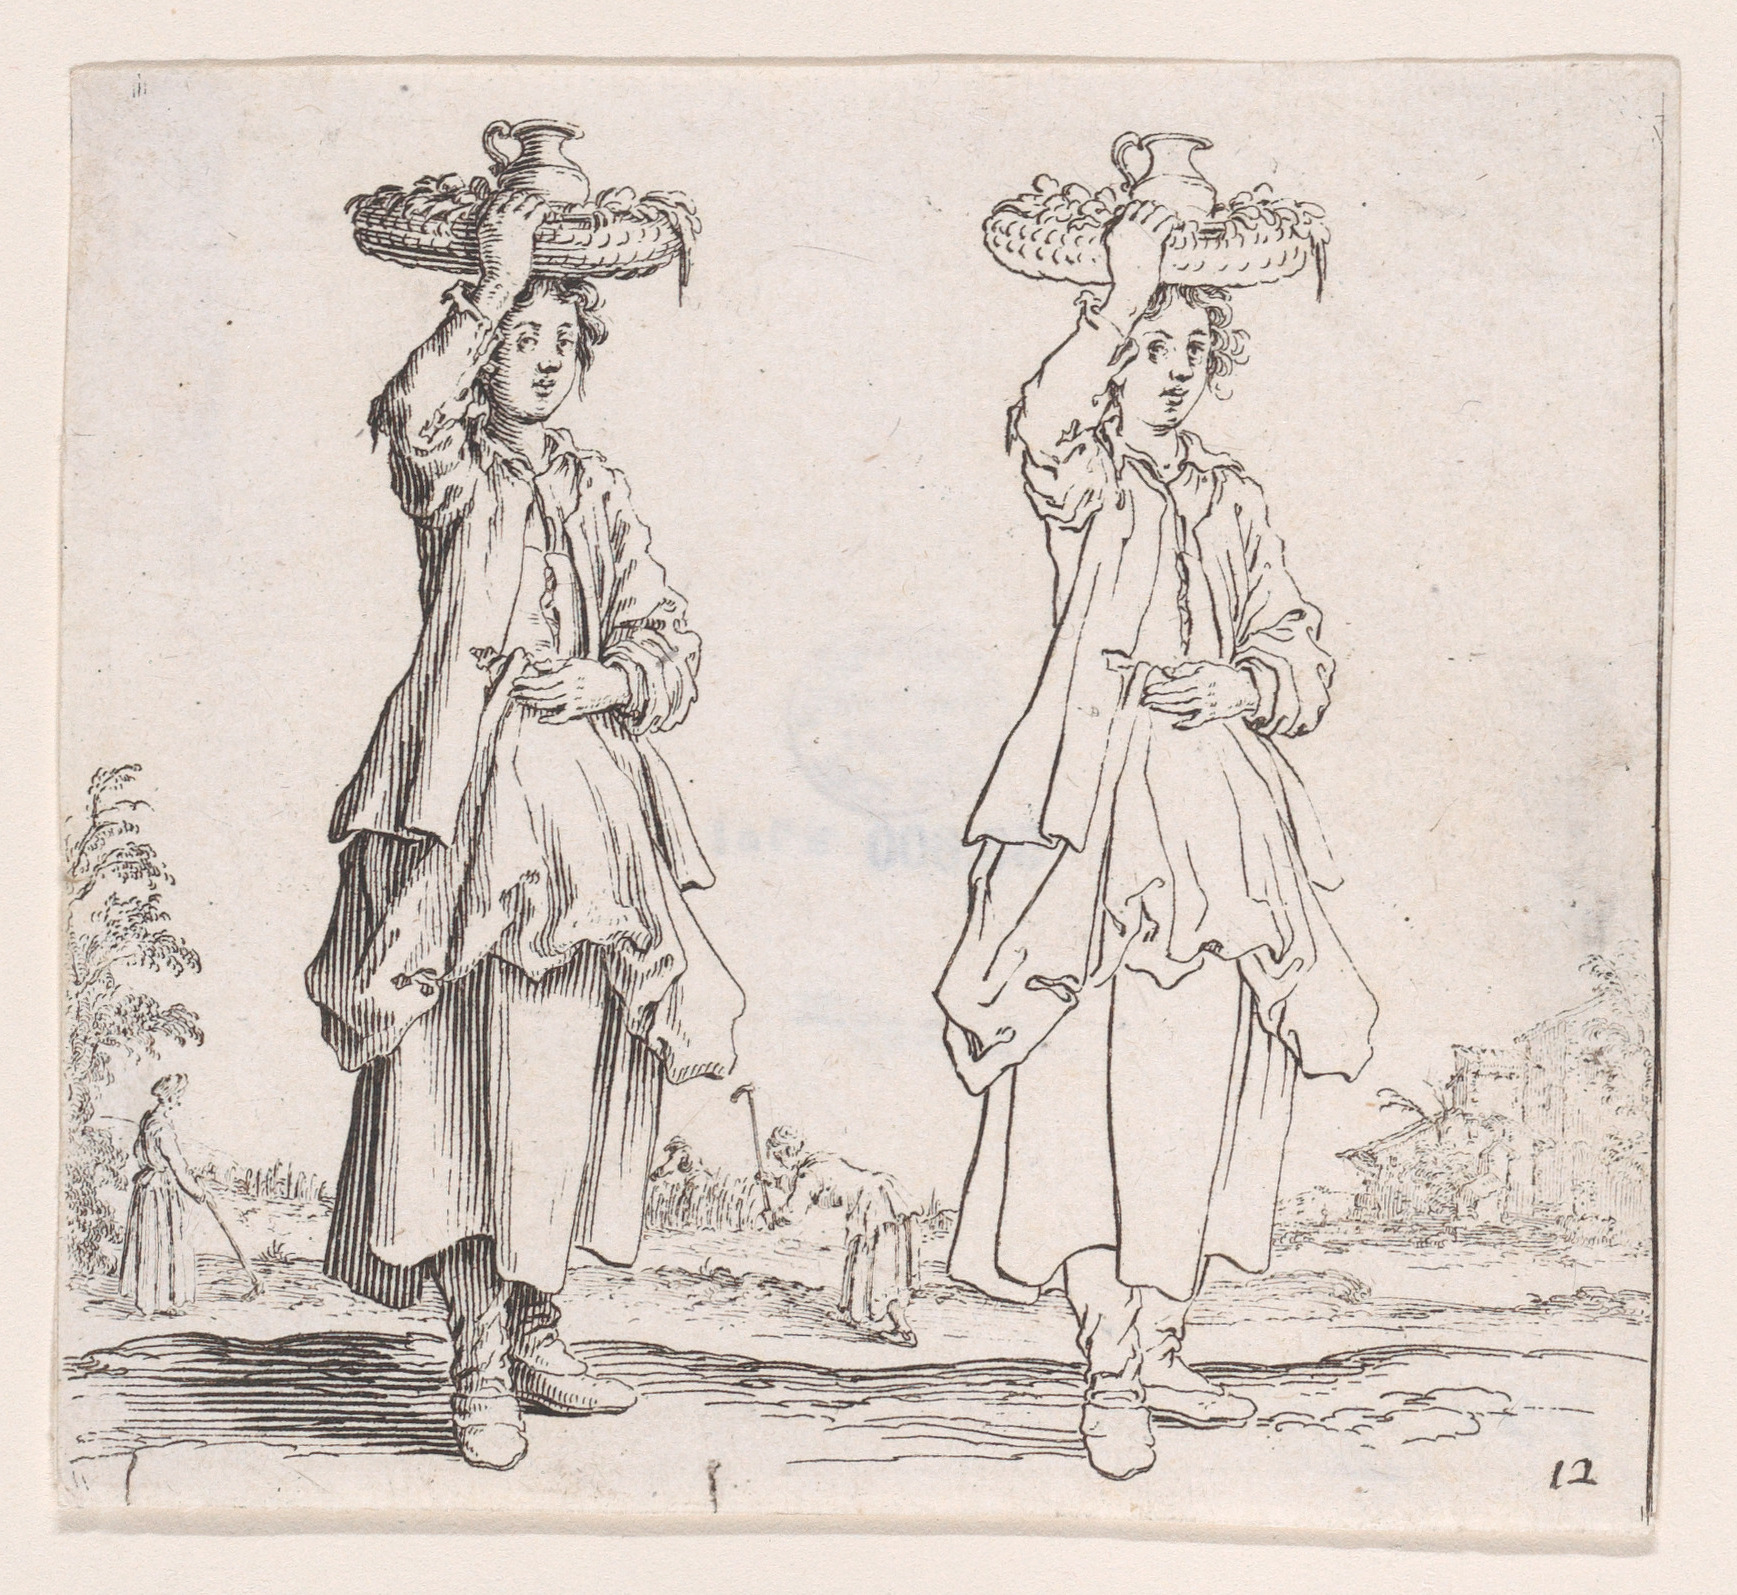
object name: print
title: La Paysanne Vue de Face, Tenant un Panier sur sa Tête (The Peasant Woman Viewed from the Front with a Basket on her Head), plate 12 from "Varie Figure" (Various Figures)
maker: jacques callot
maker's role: artist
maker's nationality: french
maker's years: 1592-1635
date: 1620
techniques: etching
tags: women,baskets